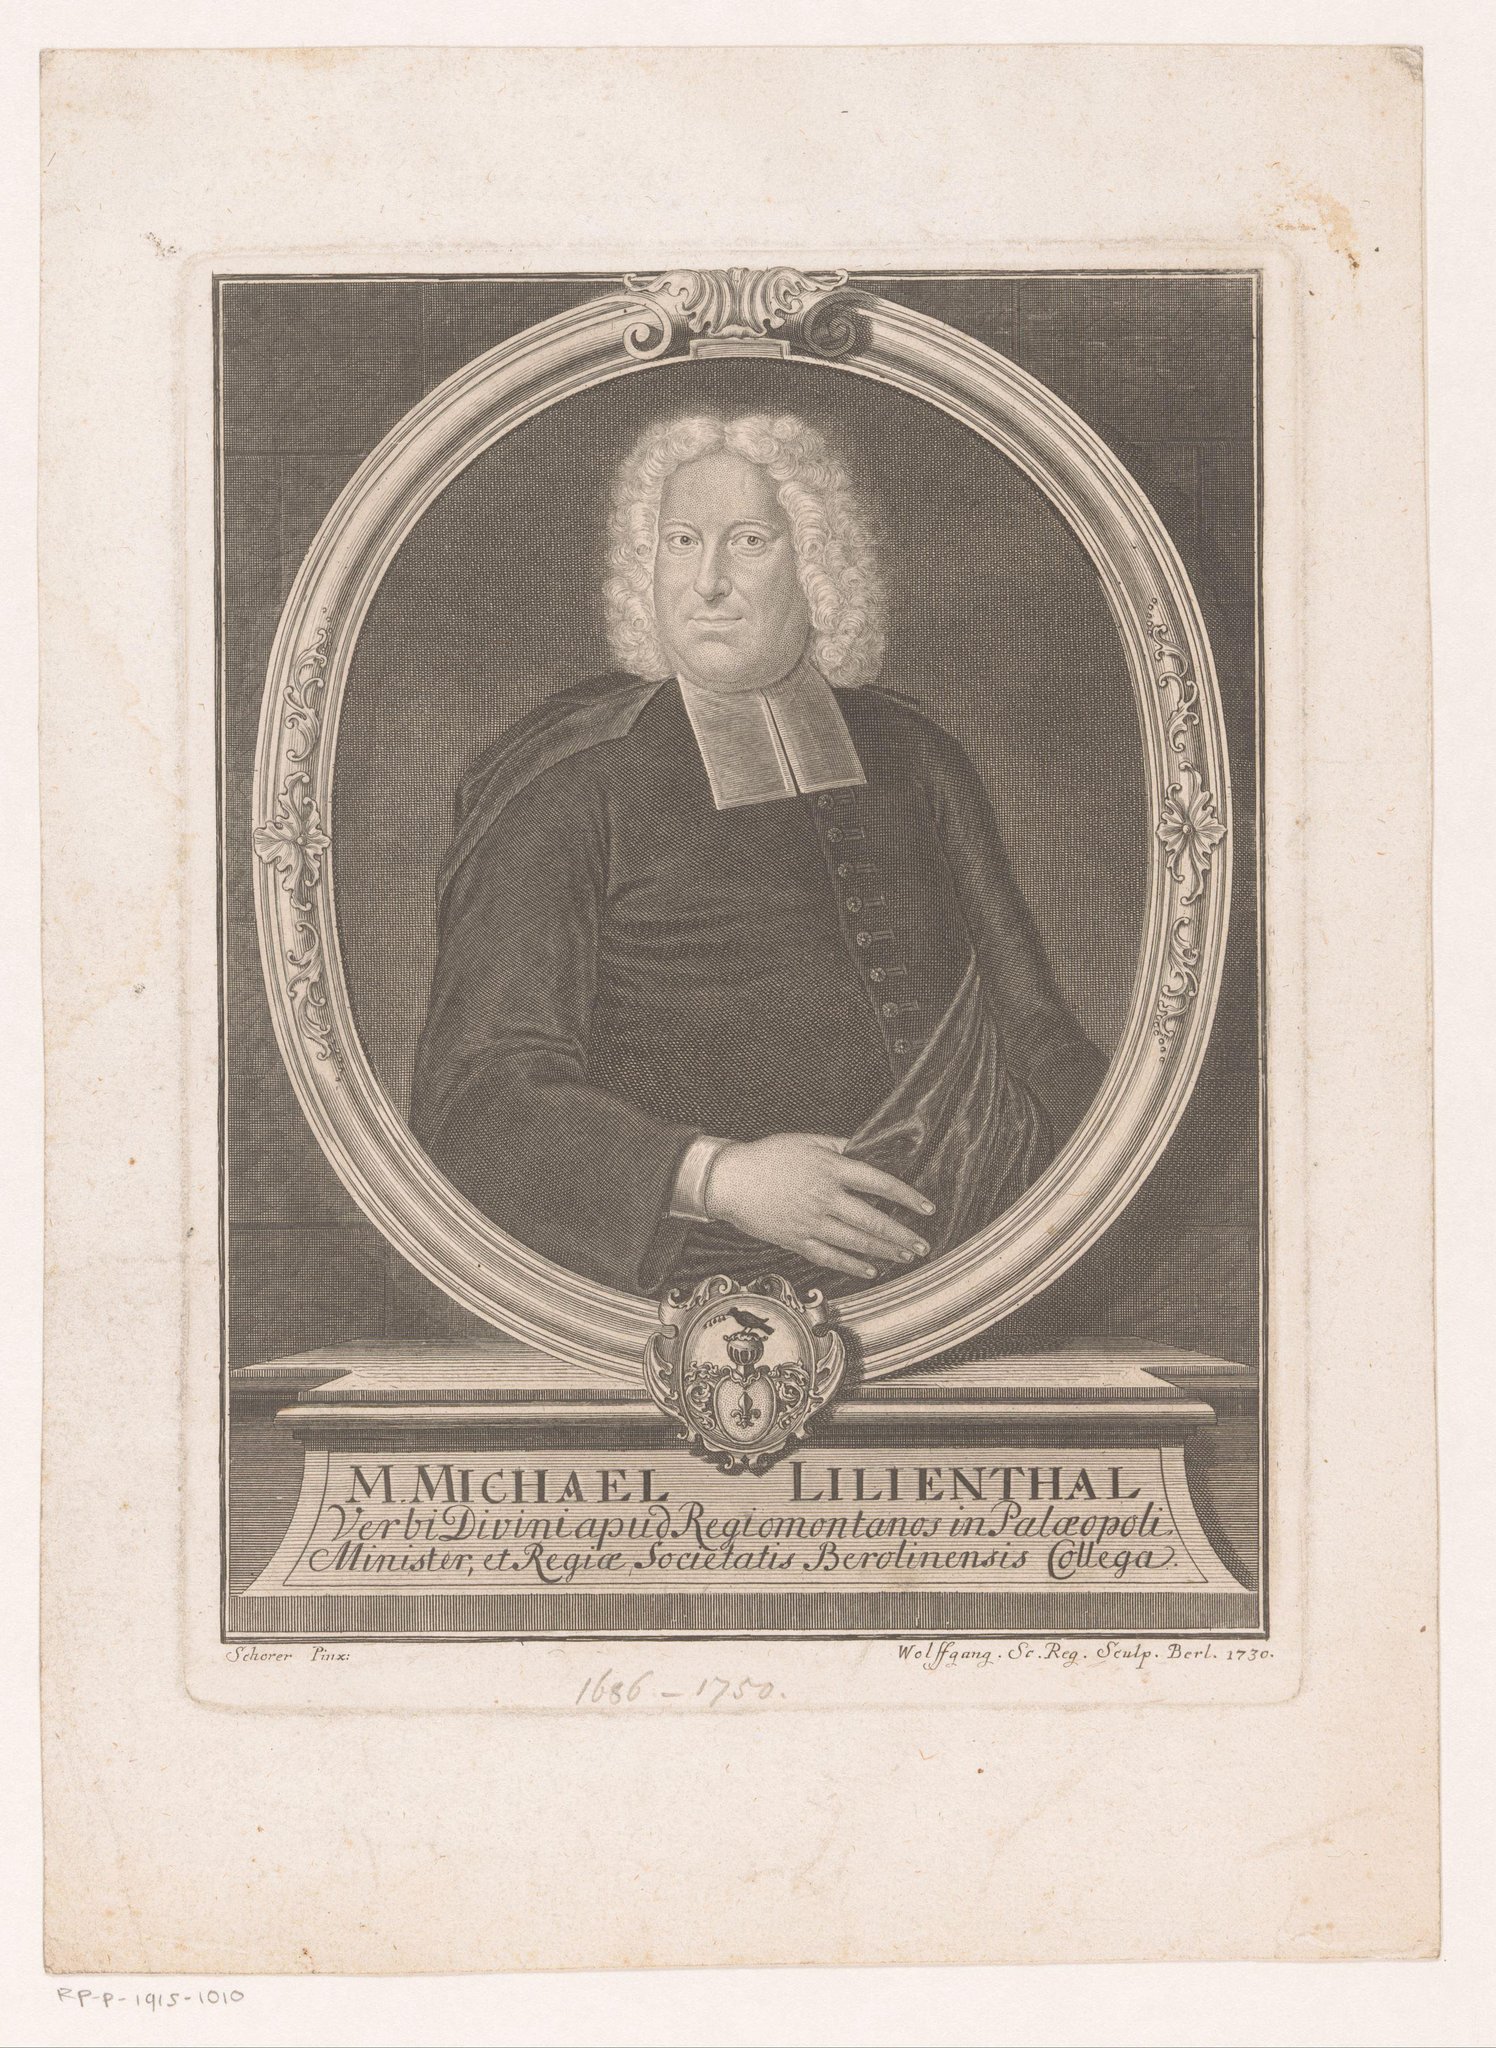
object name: print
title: Portret van Michael Lilienthal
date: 1730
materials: paper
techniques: engraving, etching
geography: berlin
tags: publisher, michael lilienthal, historical persons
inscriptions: collector's mark: Lugt 2228